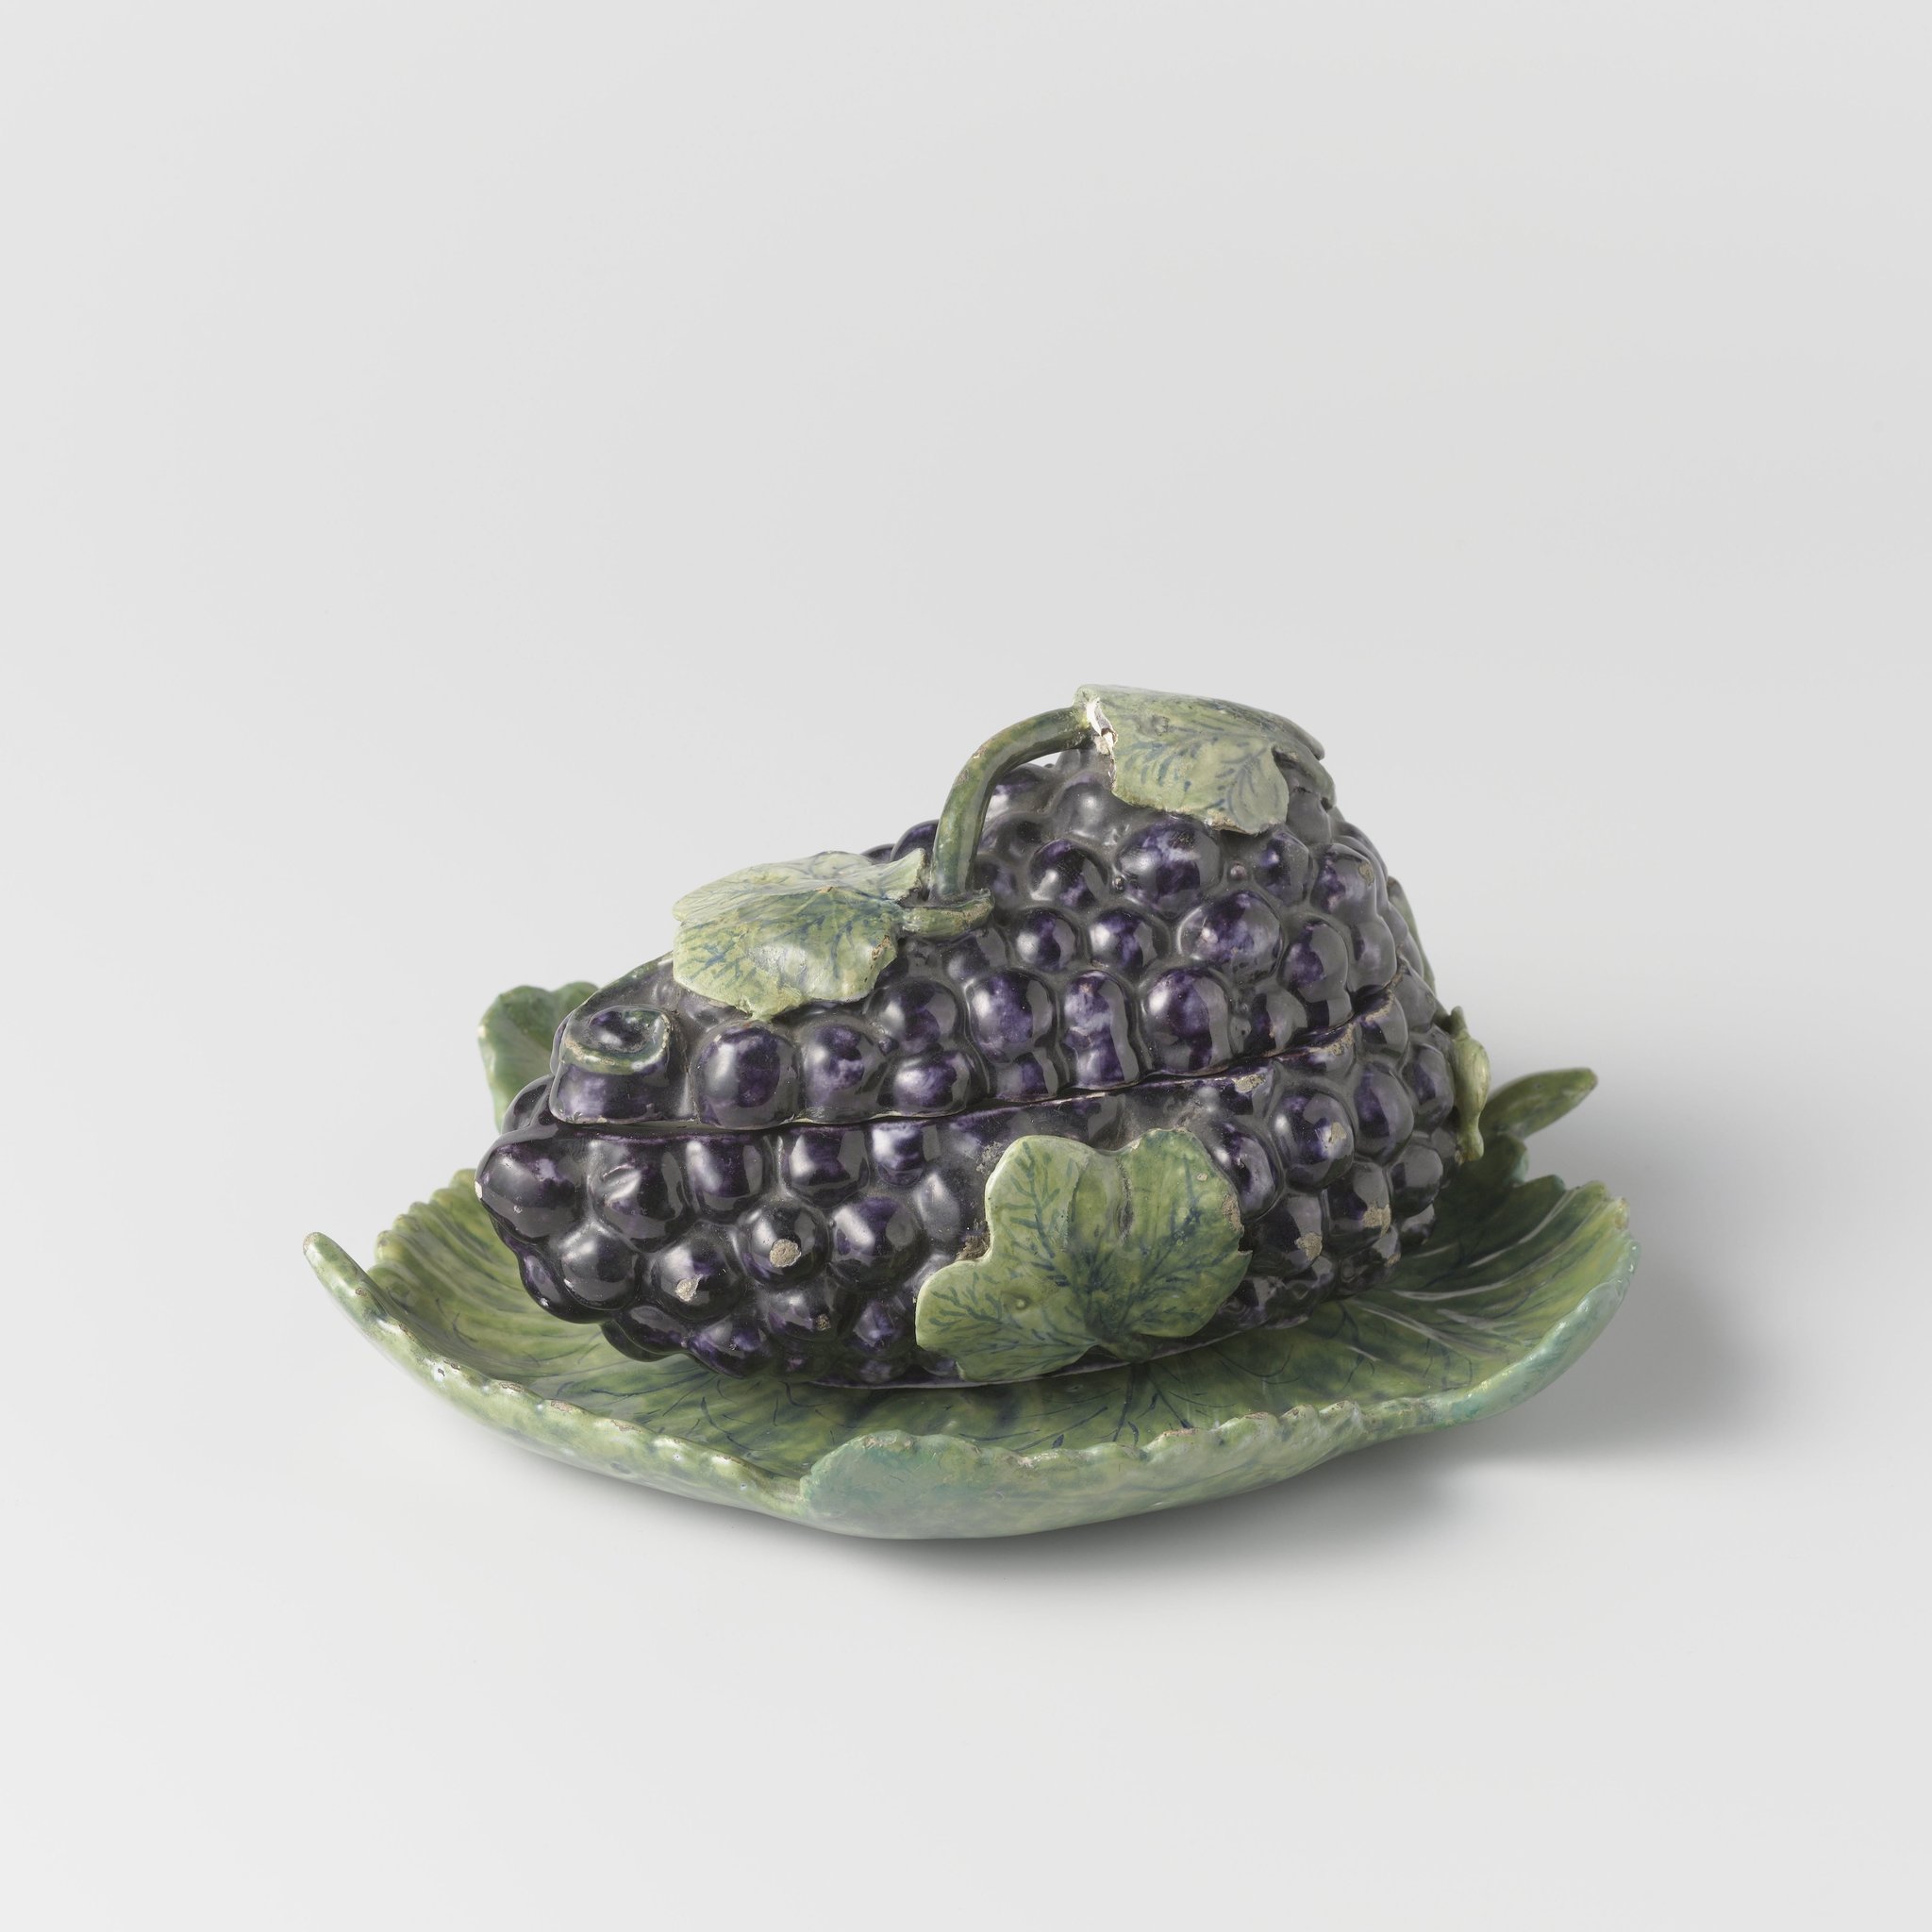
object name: tureen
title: Terrine van veelkleurig beschilderde faience, in de vorm van een druiventros, met deksel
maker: jacobus adriaens halder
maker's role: fayencier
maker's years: 1741-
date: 1765-1768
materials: faience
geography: delft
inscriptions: mark: ‘A/ IH/ 12/ 105’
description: Terrine van faience in de vorm van een druiventros, met deksel. Veelkleurig beschilderd. Met bijbehorende onderschotel.